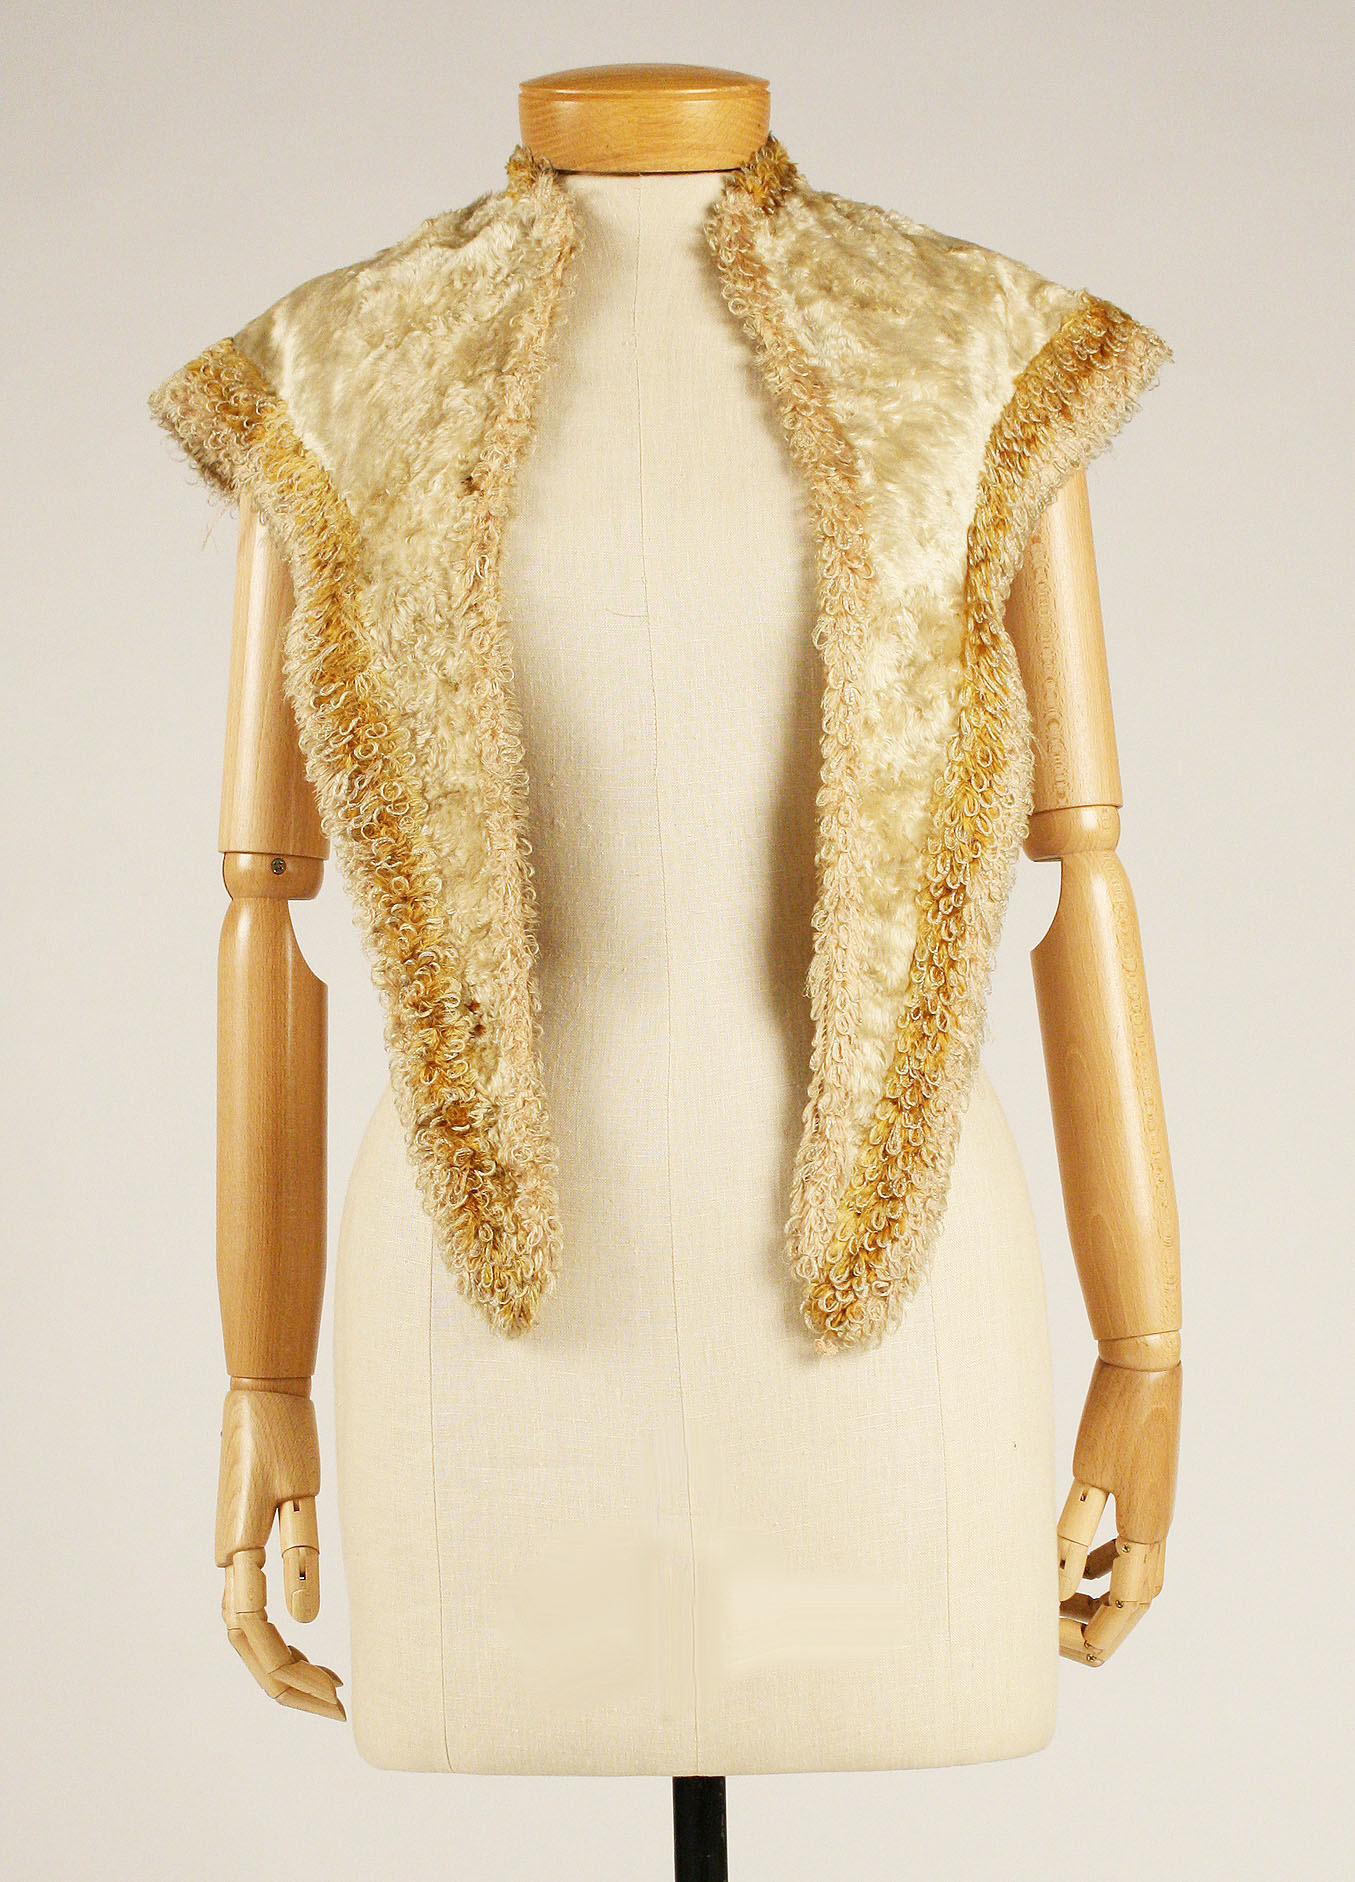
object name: collar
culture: italian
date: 1820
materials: silk